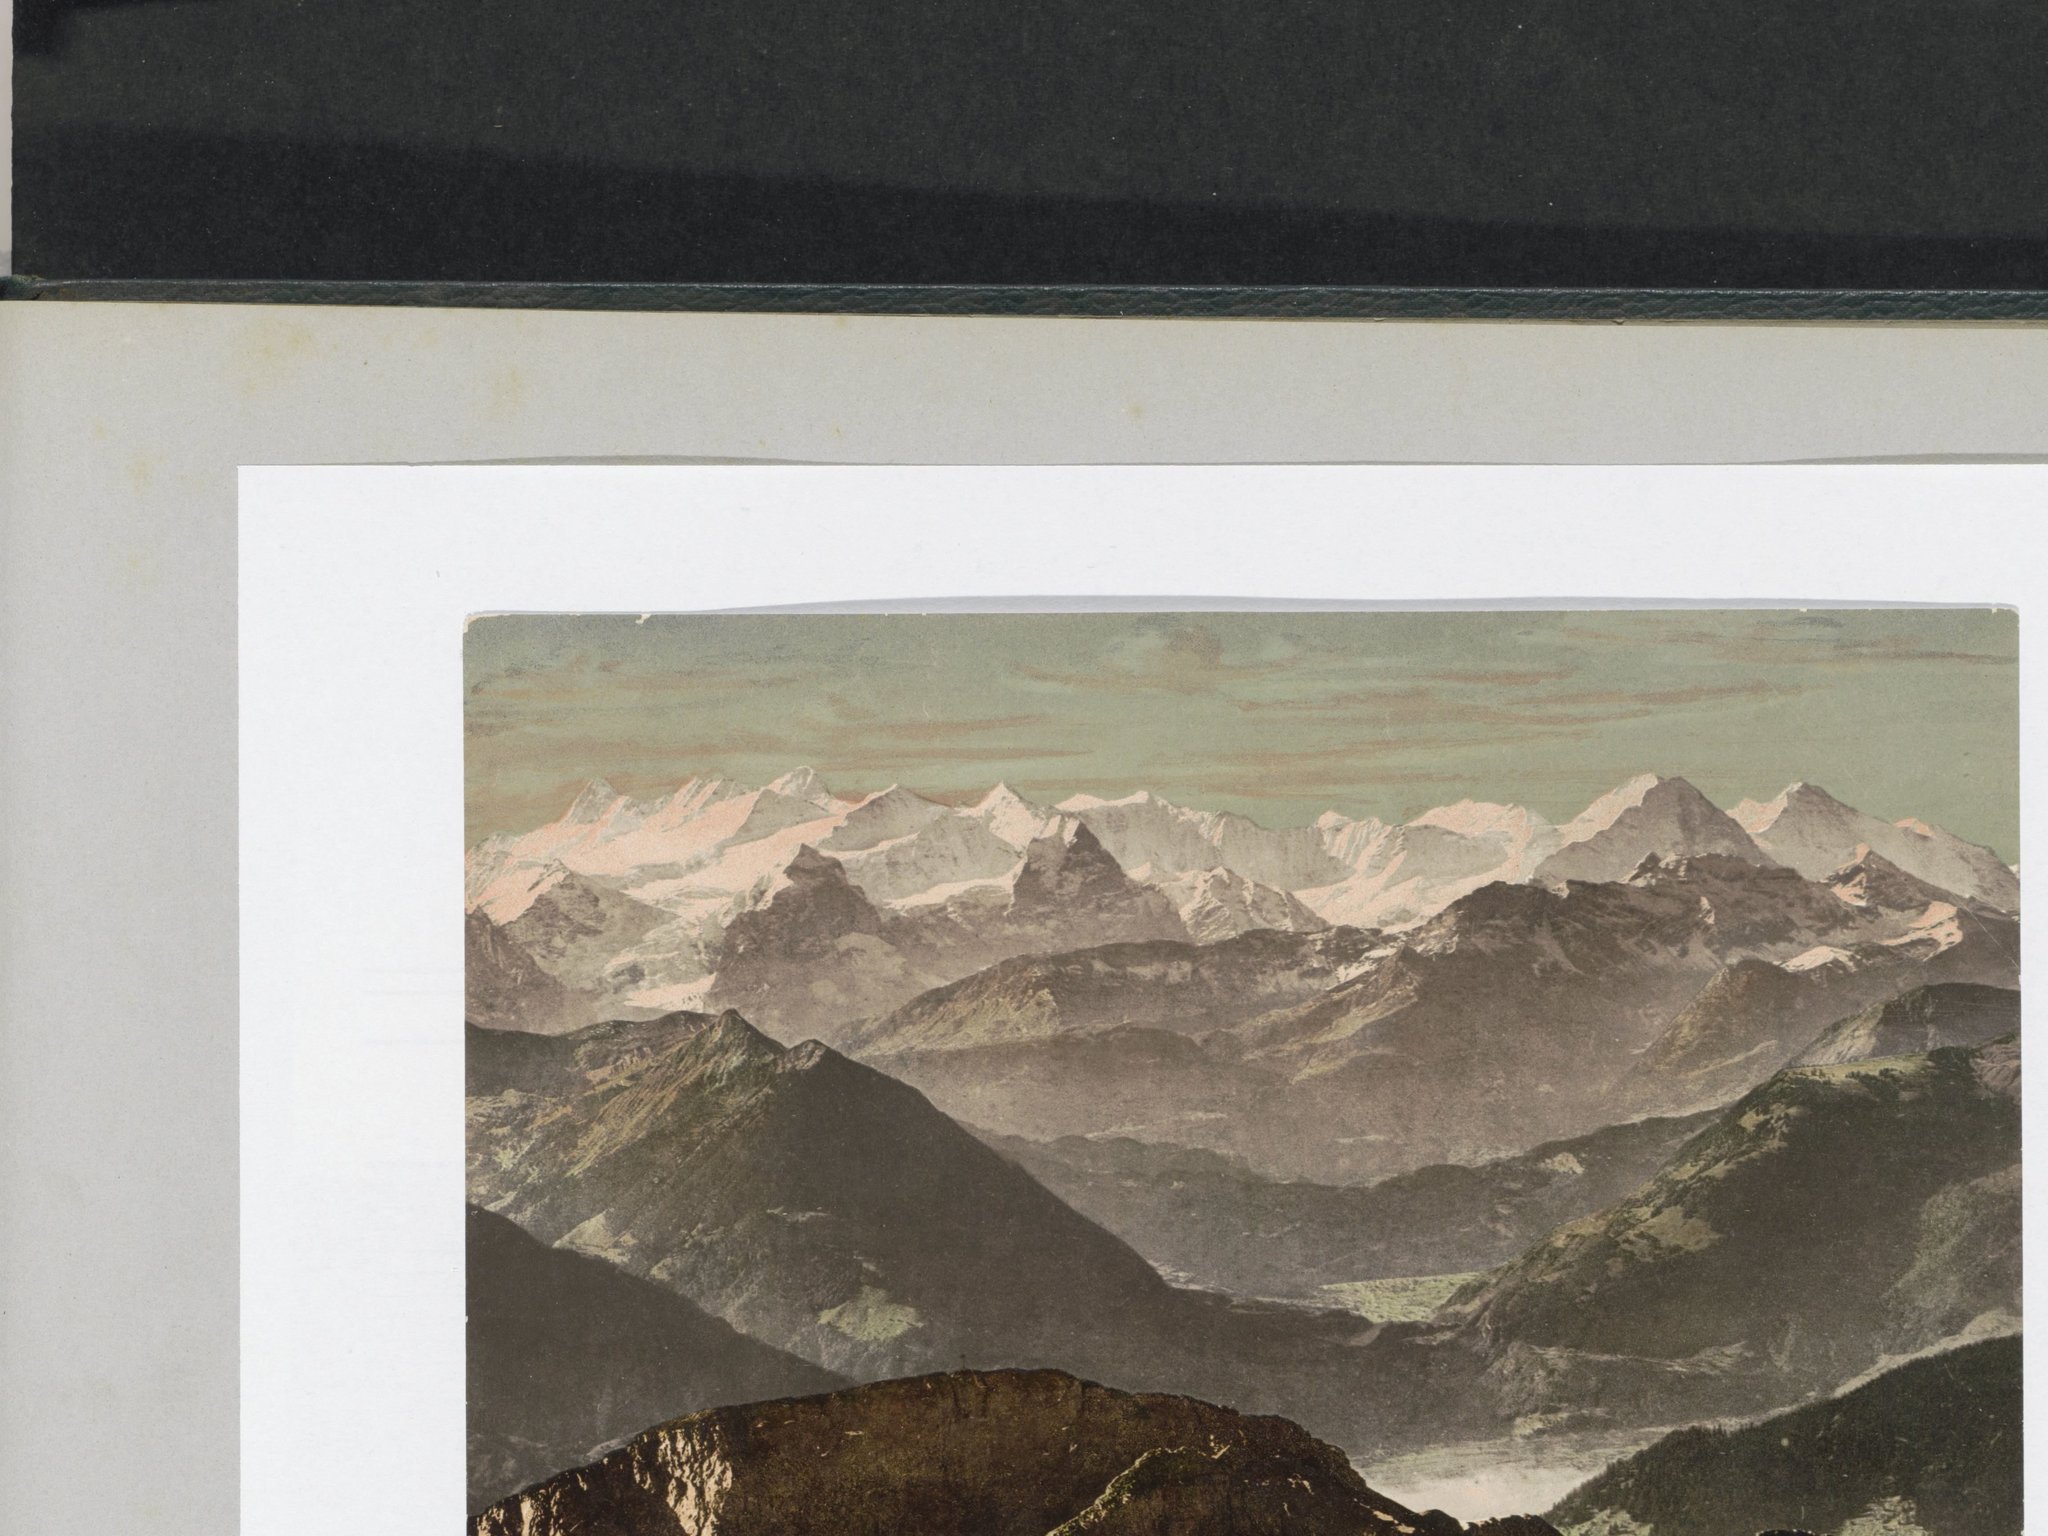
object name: photomechanical print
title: Gezicht op de Alpen vanaf de Pilatus te Zwitserland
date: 1896-1897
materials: paper, photographic process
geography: interlaken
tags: mountain-range, snow peaks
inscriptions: inscription: ‘9281. P.Z. - Berneralpen, vom Pilatus aus’, inscription: ‘Photochrom/ Dépôt M. Stump/ Editeur/ Interlaken (Suisse)’